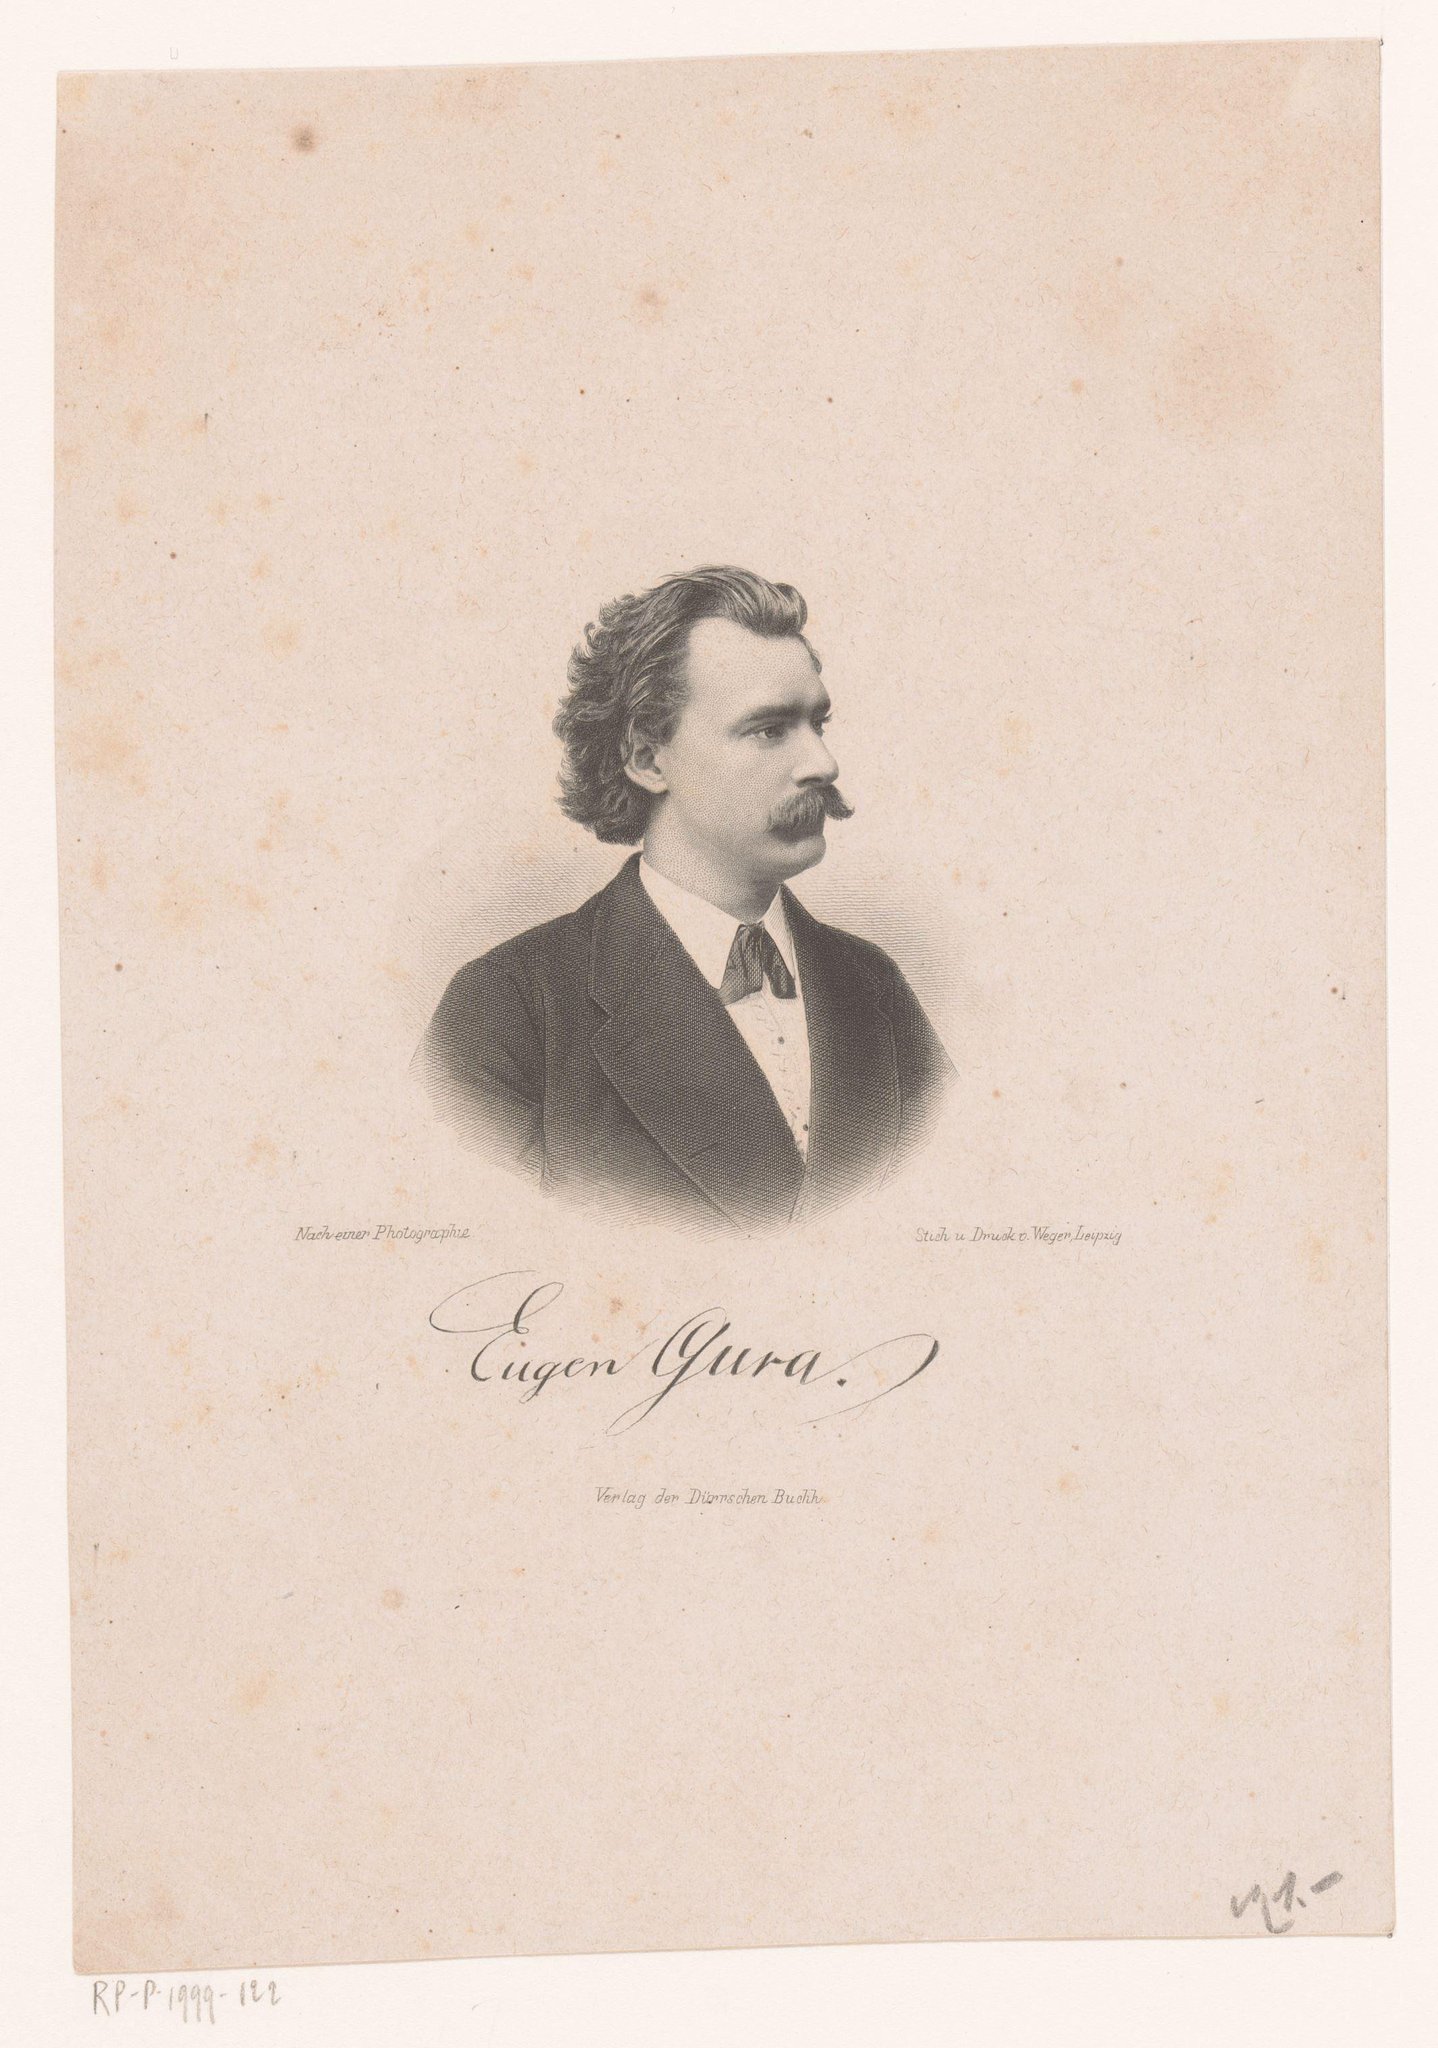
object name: print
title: Portret van Eugen Gura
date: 1870-1892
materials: paper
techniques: engraving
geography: leipzig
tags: historical persons, portrait of opera-singer, opera-singer (male)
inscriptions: collector's mark: Lugt 2228, collector's mark: Lugt 4100, collector's mark: Lugt 2760